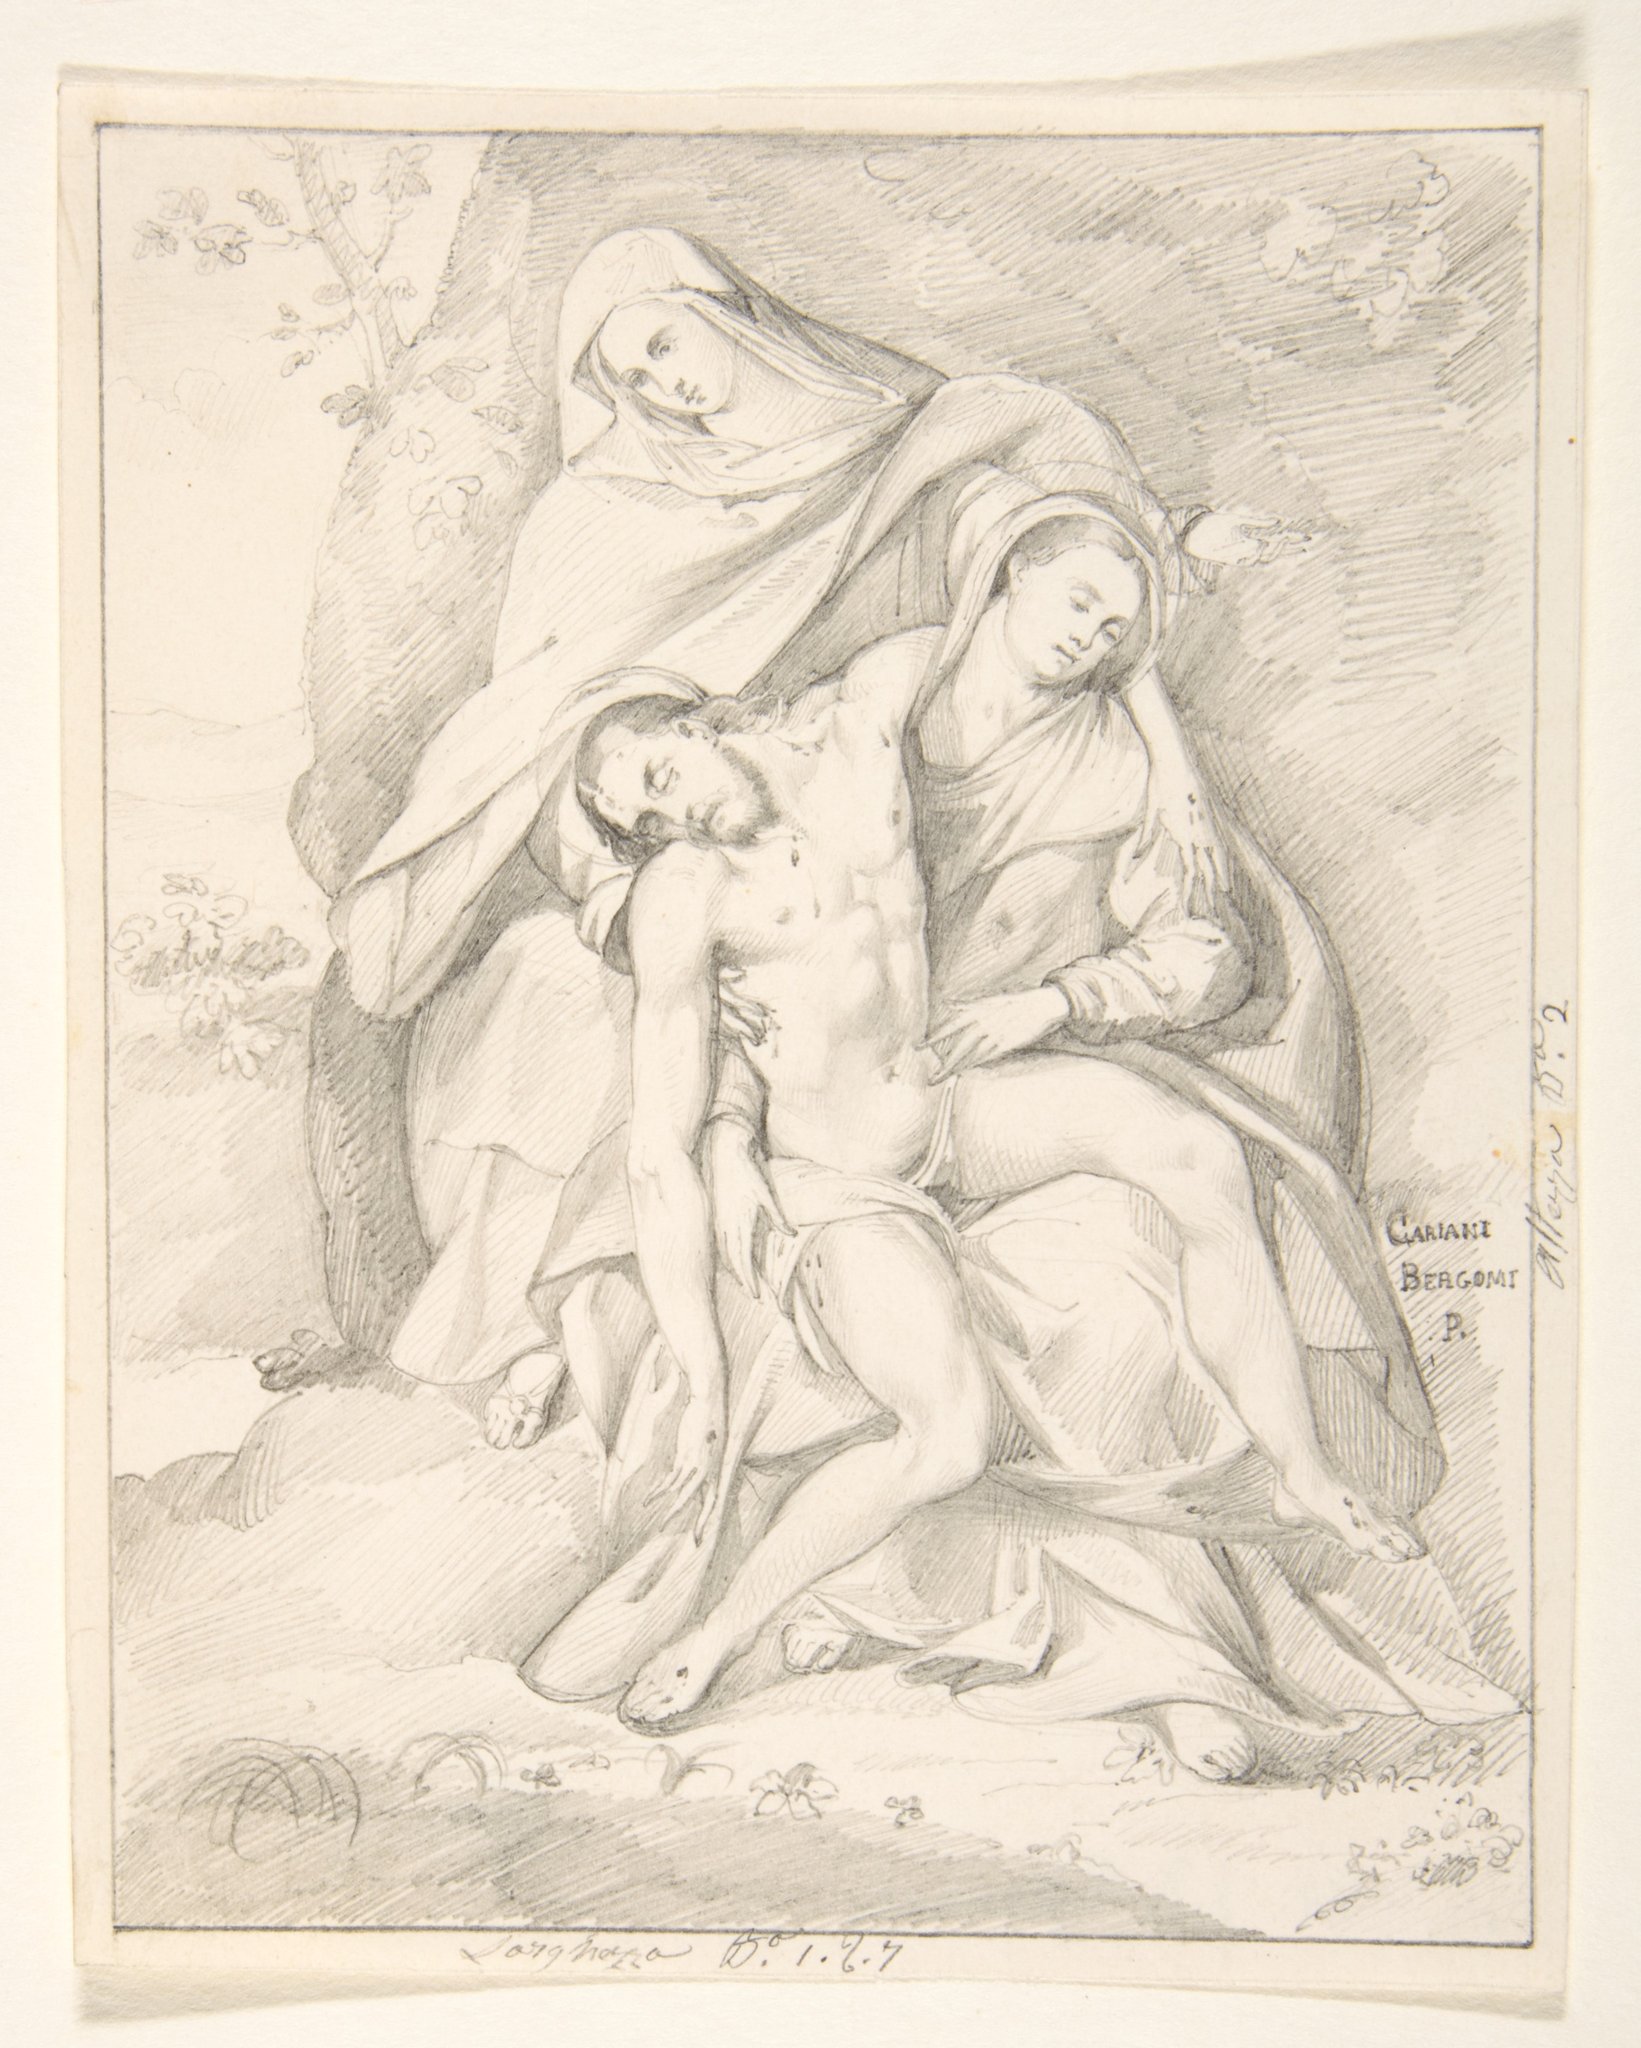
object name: drawing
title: Pietà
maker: johann david passavant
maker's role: artist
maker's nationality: german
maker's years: 1787-1861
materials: graphite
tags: sadness,christ,virgin mary